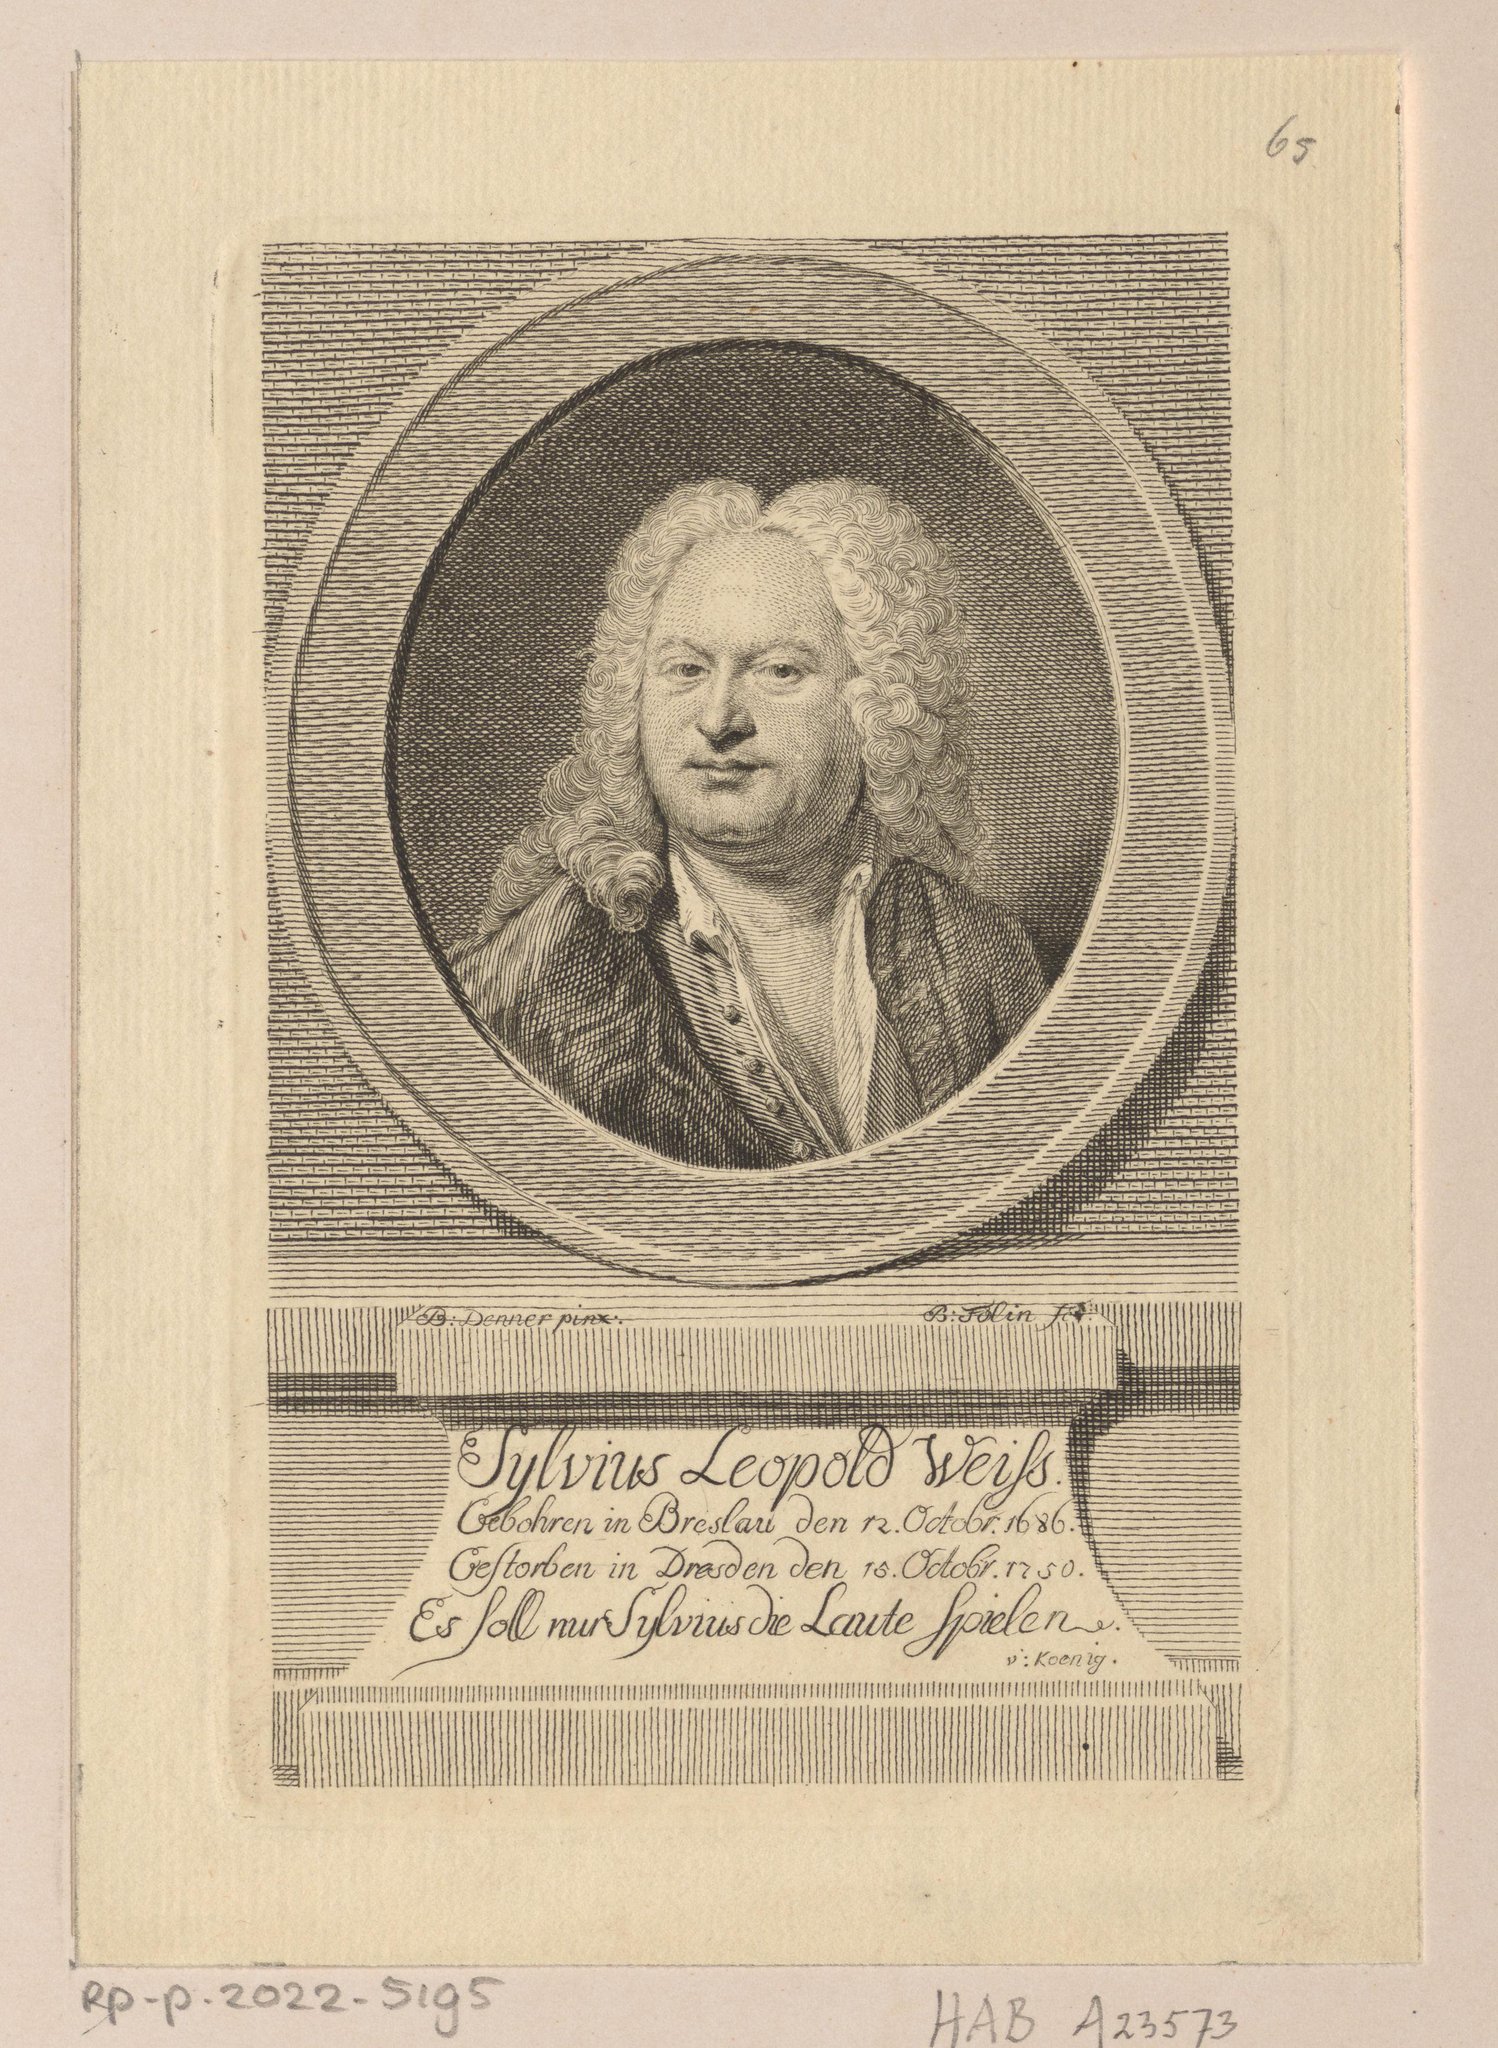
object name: print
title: Portret van Sylvius Leopold Weiss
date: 1765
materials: paper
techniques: engraving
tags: historical persons, portrait of composer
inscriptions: number: ‘65.’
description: Prent waarschijnlijk uit: Neue Bibliothek der schönen Wissenschaften und der freyen Künste. Leipzig: Johann Gottfried Dyck, 1765.